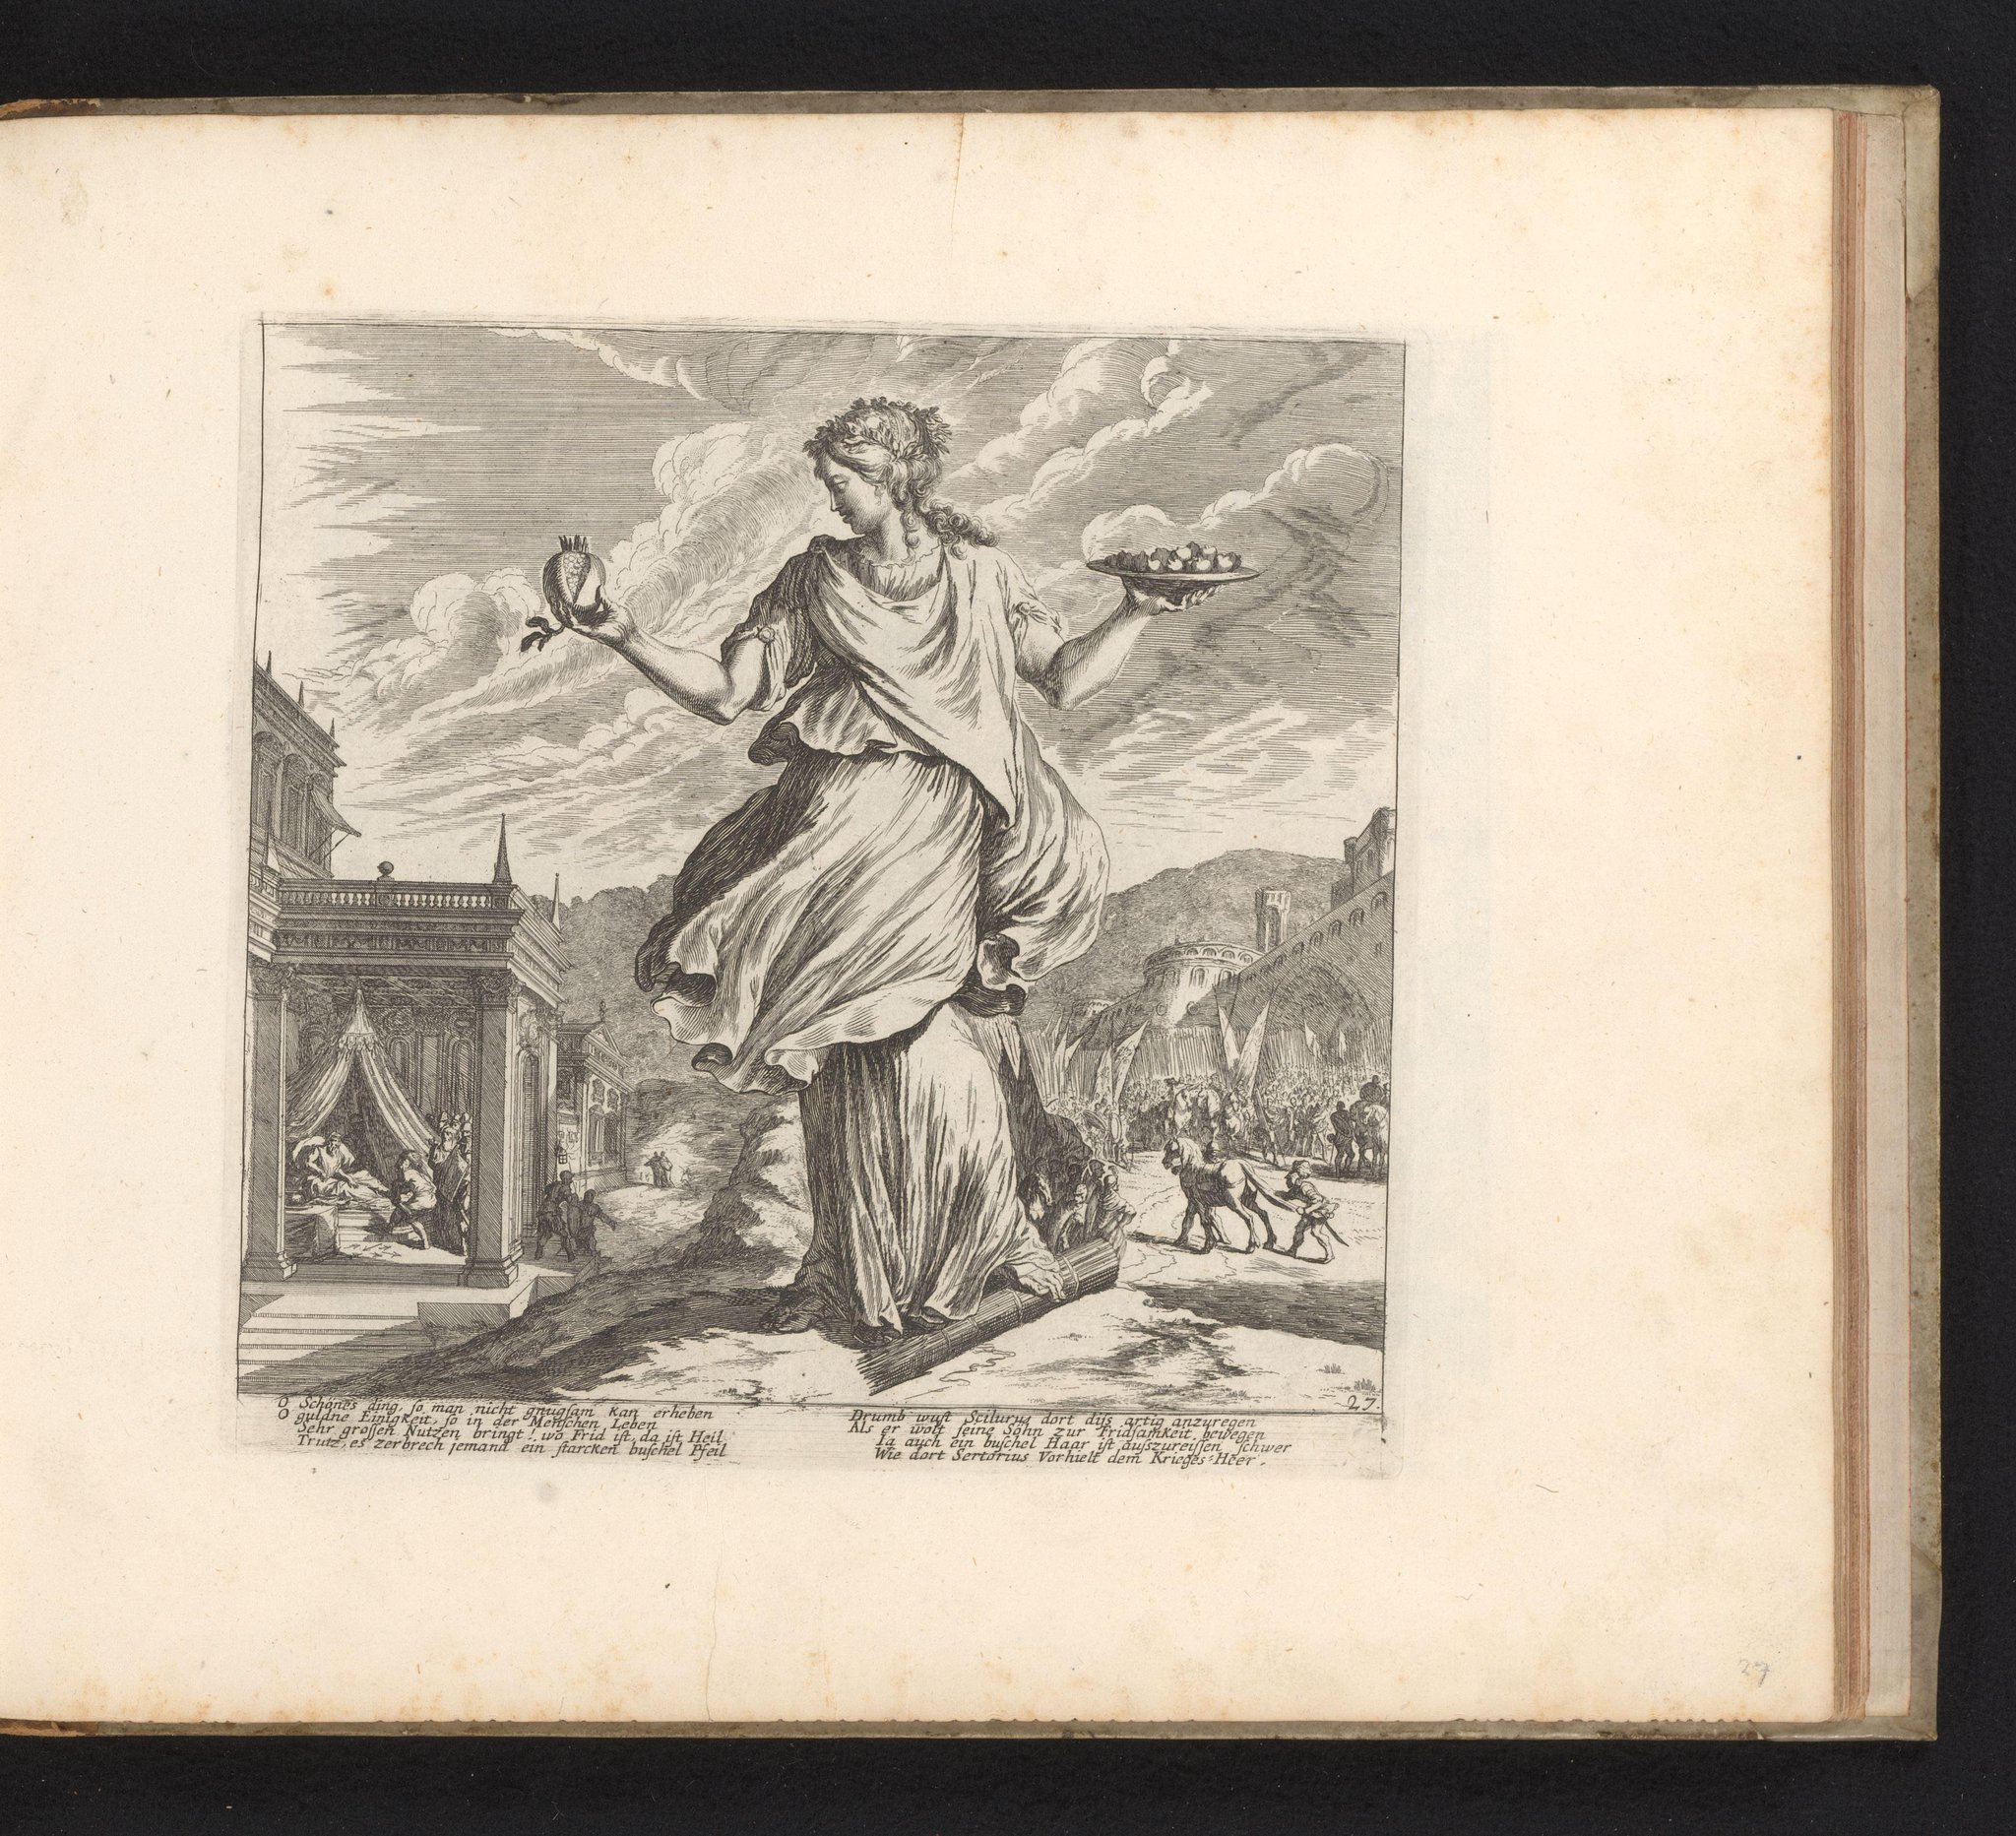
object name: print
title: Personificatie van Eendracht en Kracht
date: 1670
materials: paper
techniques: etching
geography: augsburg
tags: fortitude, 'fortitudo' ~ one of the four cardinal virtues, agreement, unity; 'concordia', 'concordia insuperabile', 'concordia militare', 'concordia di pace', 'unione civile' (ripa), fruits: pomegranate (+ plants used symbolically), strength, power; 'fortezza', 'fortezza d'animo e di corpo', 'fortezza del corpo congiunta con la generosità dell'animo', 'fortezza & valore del corpo congiunto con la prudenza & virtù del animo', 'forza' (ripa)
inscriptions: collector's mark: Lugt 2228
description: De verhalen van de onbreekbare pijlenbundel (een metafoor afkomstig van Scilurus, koning van de Scythen, beschreven door Plutarchus) en het uittrekken van een paardenstaart (een uitspraak door Quintus Sertorius, generaal van het Romeinse leger, beschreven door Plutarchus) zijn zinnebeelden die het bundelen van kracht, (strategisch) doorzettingsvermogen en concordantie benadrukken. Tekst in het Duits in de ondermarge. Rechtsonder genummerd: 27. Prent maakt deel uit van een album.